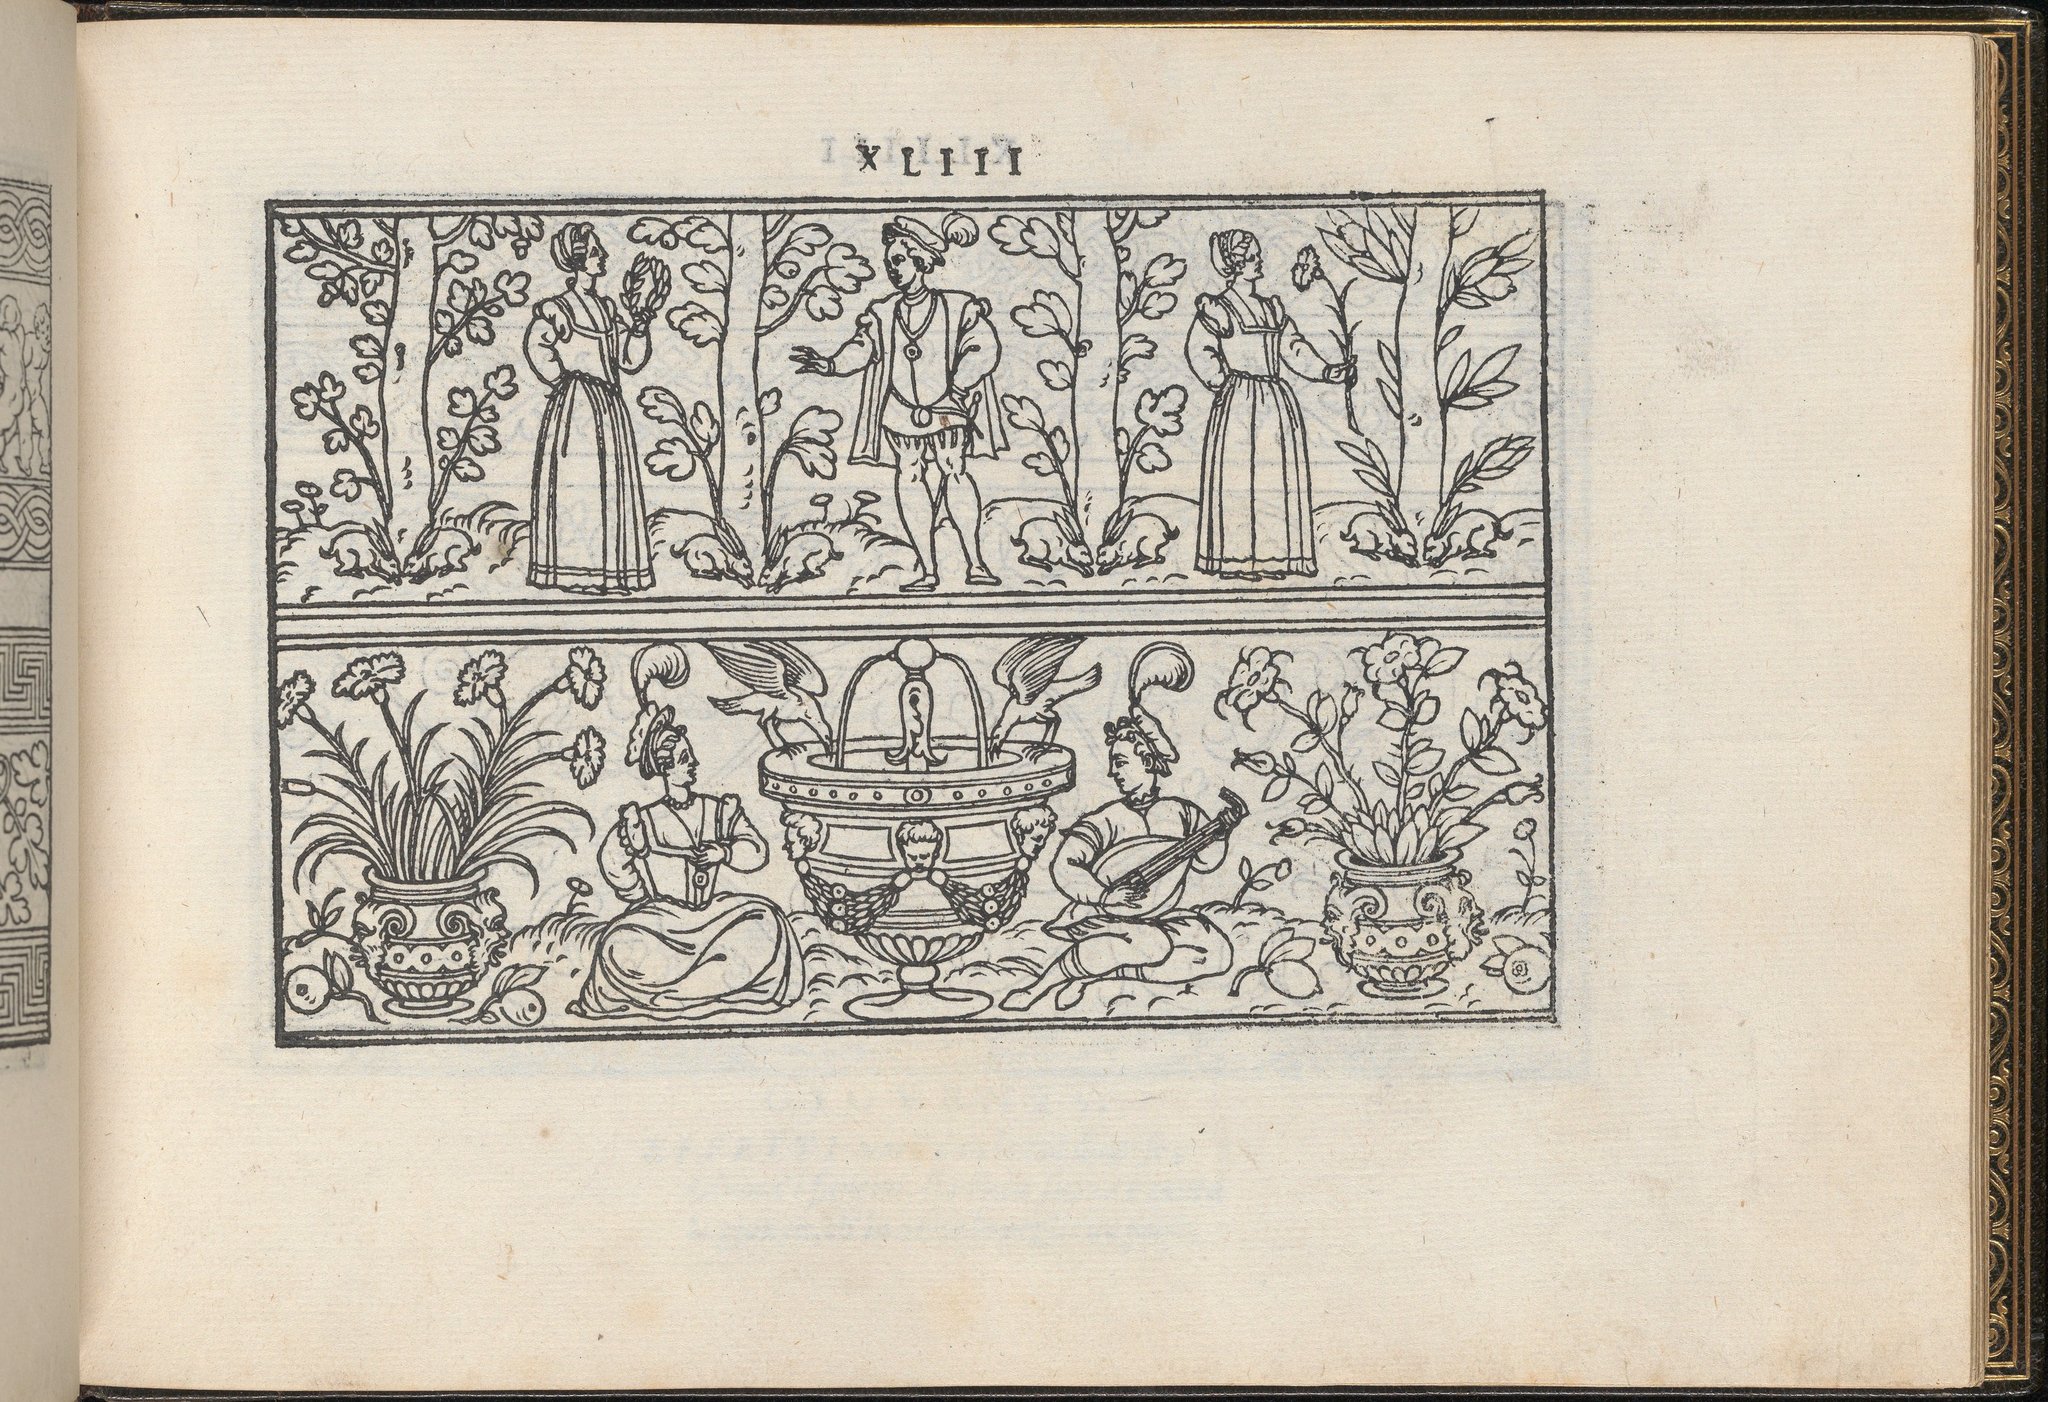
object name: book print ornament architecture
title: La Vera Perfettione del Disegno di varie sorti di recami, page 22 (recto)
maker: giovanni ostaus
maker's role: publisher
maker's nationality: italian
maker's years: 1507-1607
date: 1567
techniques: woodcut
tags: men,women,flowers